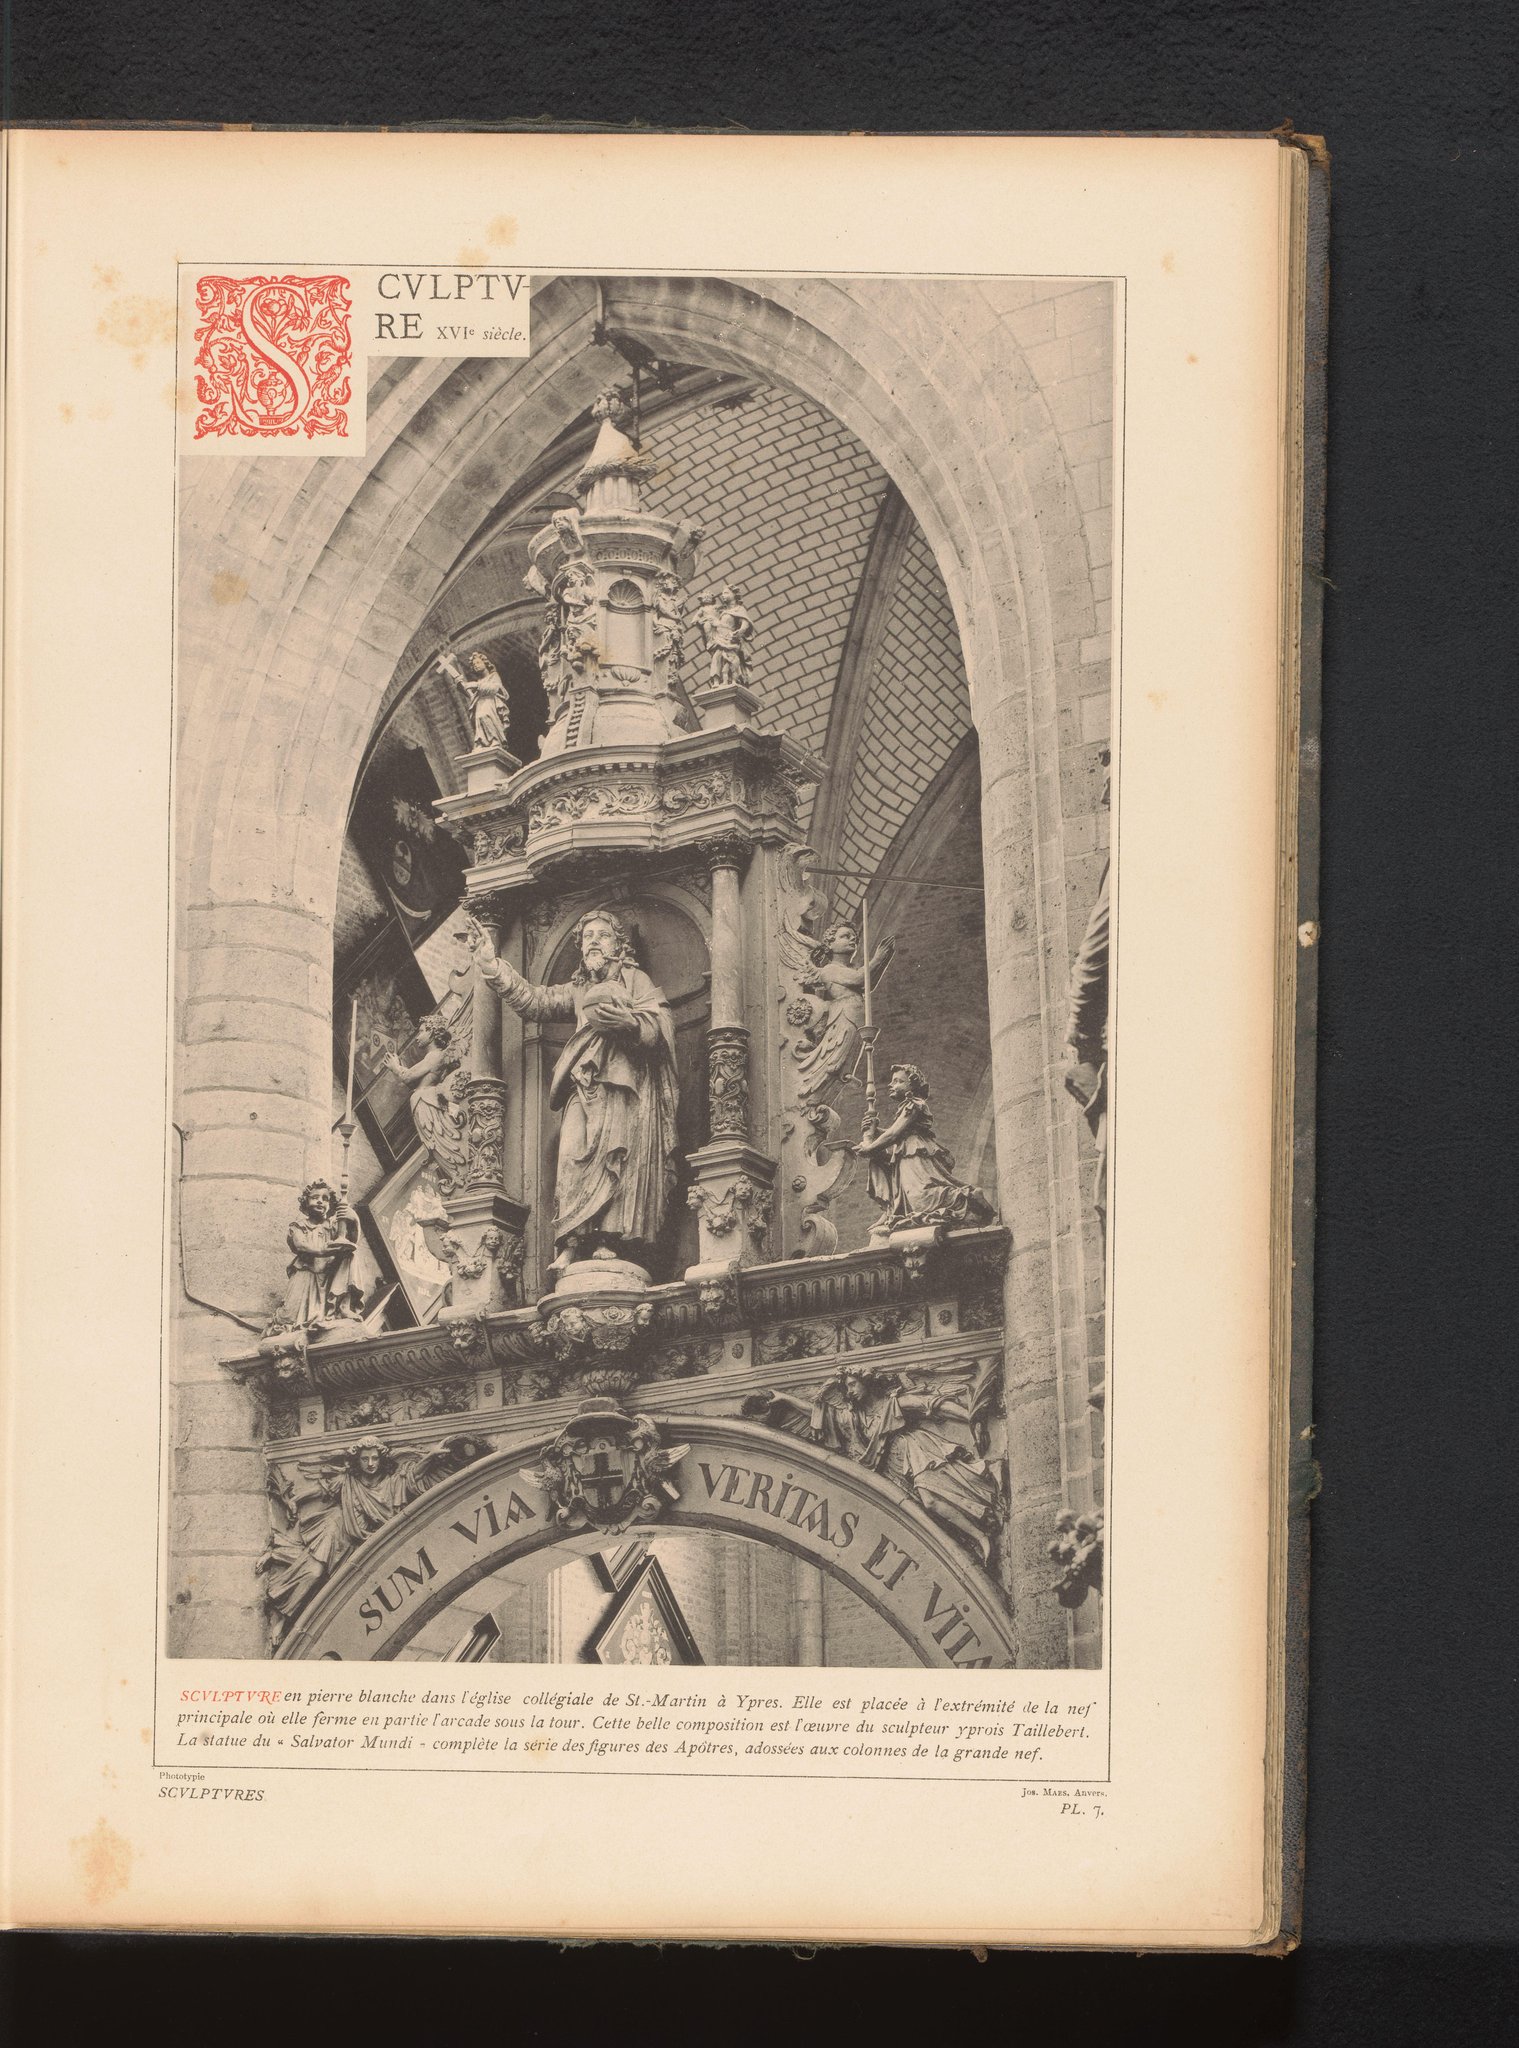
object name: photomechanical print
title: Sculpture, XVIe siècle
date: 1882-1887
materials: paper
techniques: photograph, photolithography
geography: antwerp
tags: 'salvator mundi', making a blessing gesture; an orb in his hand or at his feet, church (exterior), piece of sculpture, reproduction of a piece of sculpture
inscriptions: inscription: ‘SCULPTURES. - PL. 7.’, inscription: ‘SCULPTURES en pierre (...)’, monogram: ‘JJvY’